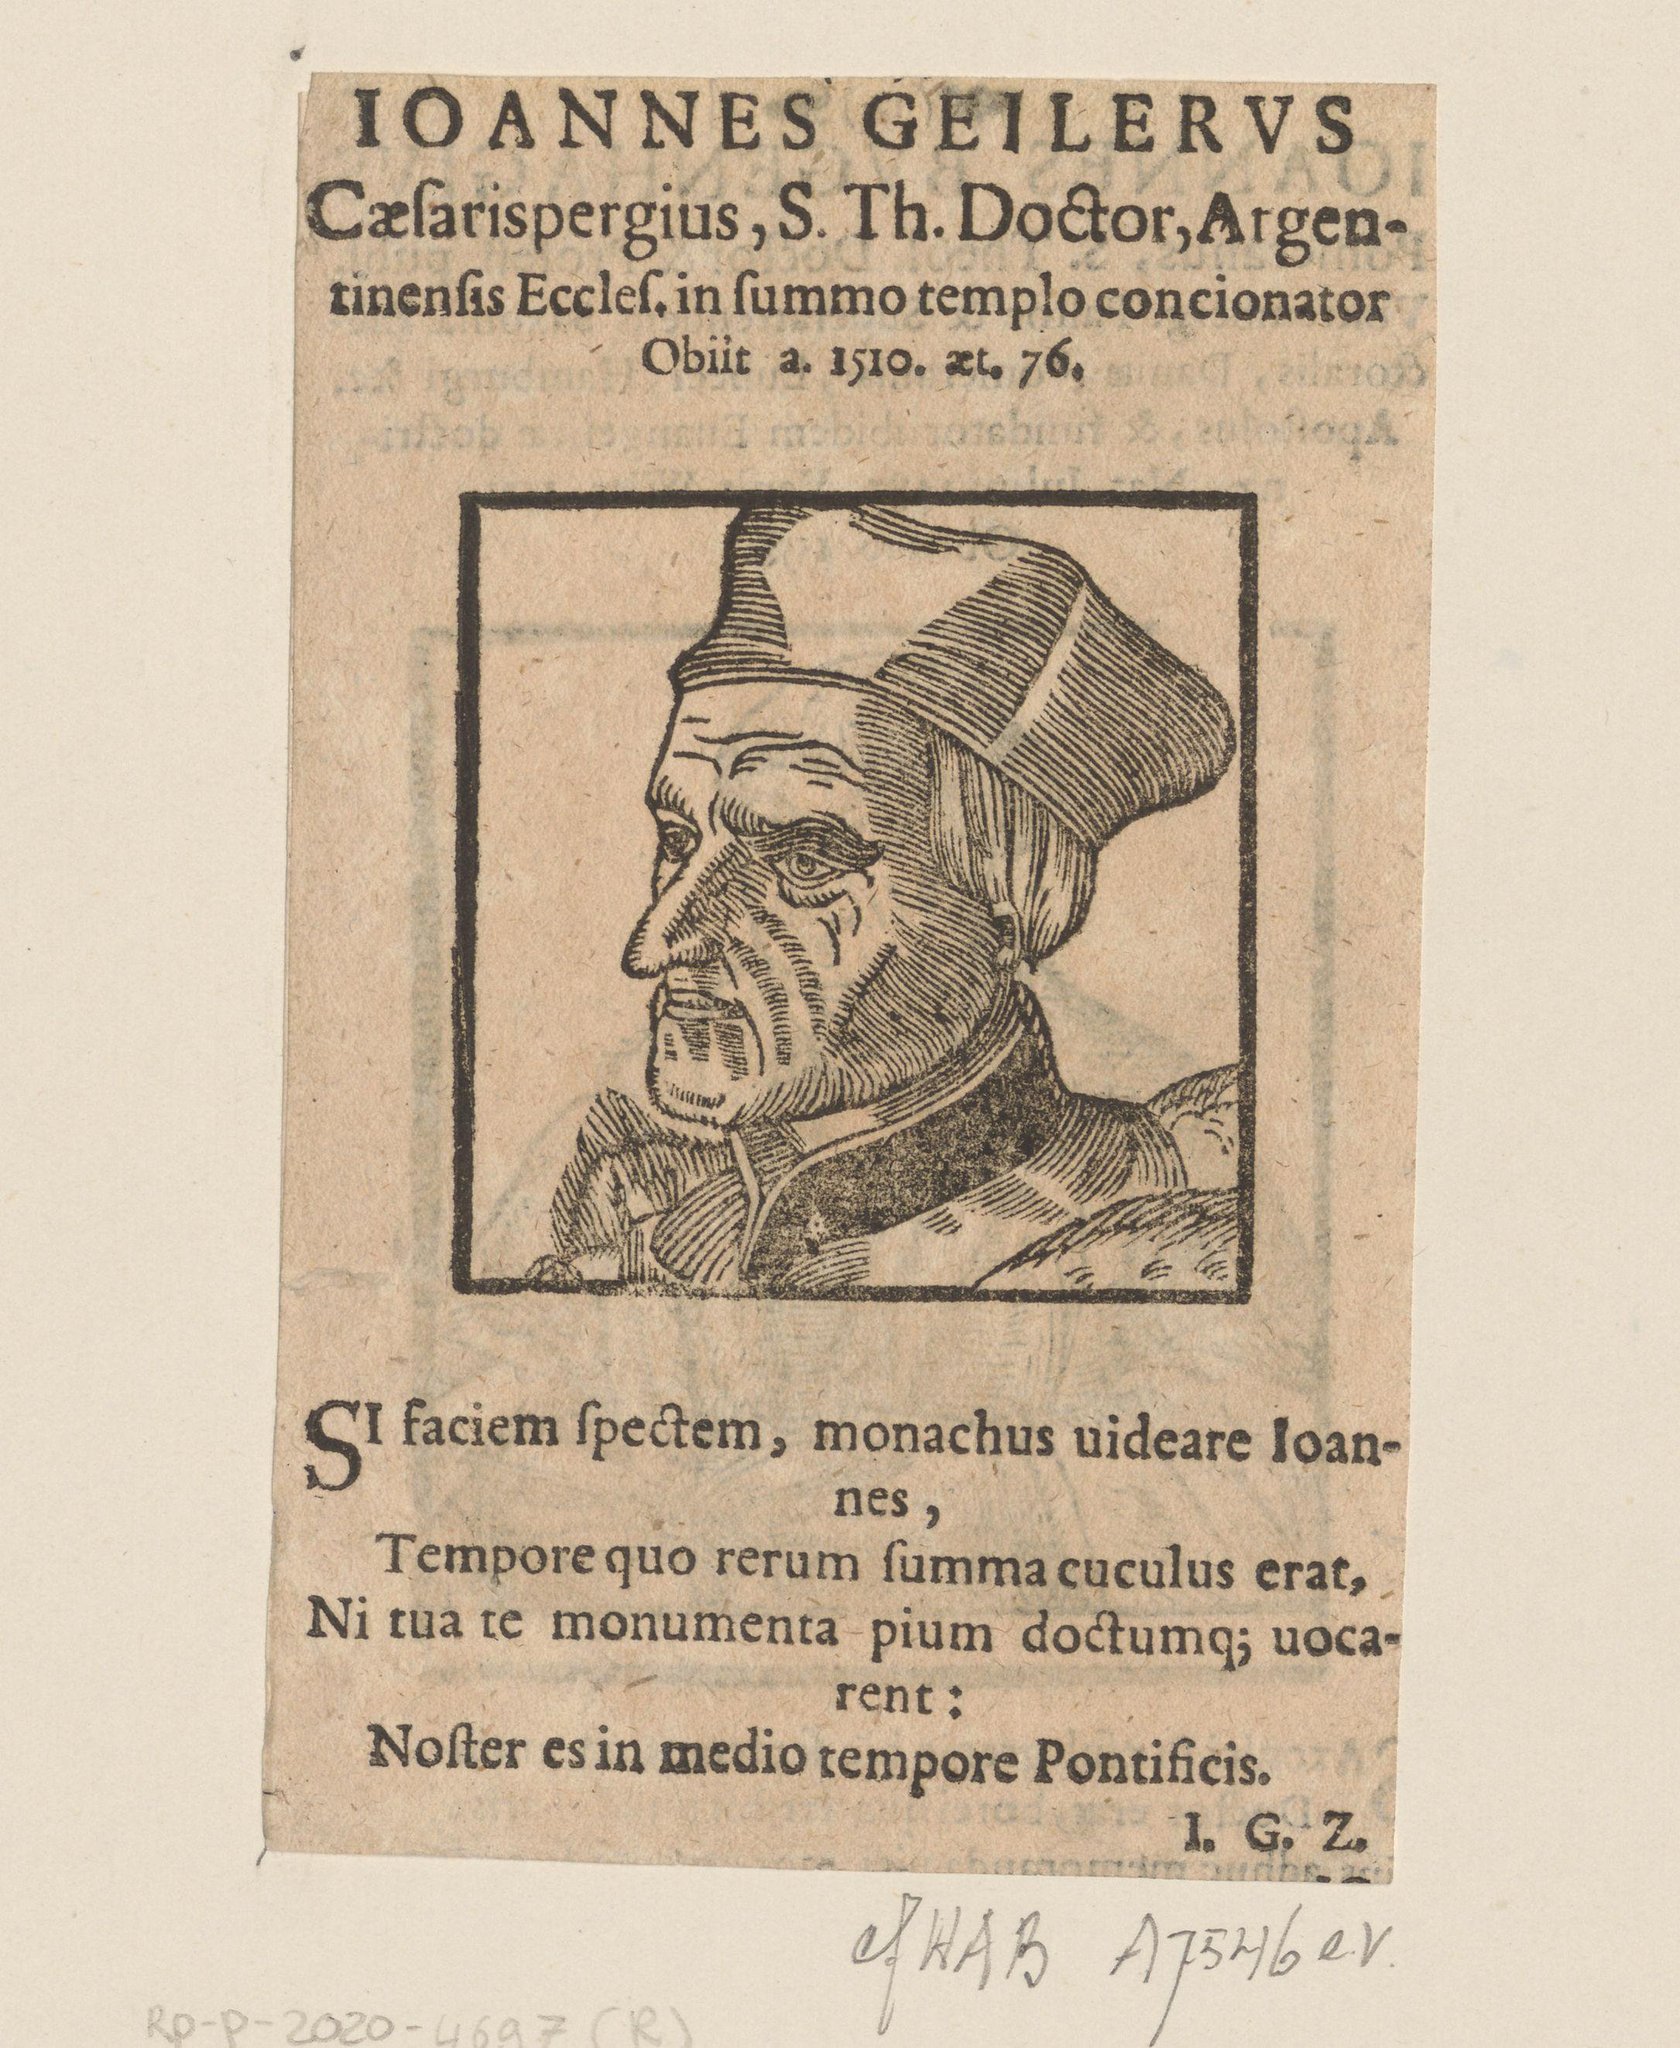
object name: print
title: Portret van Johann Geiler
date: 1550-1650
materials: paper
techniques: letterpress printing, engraving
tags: theologian, historical persons